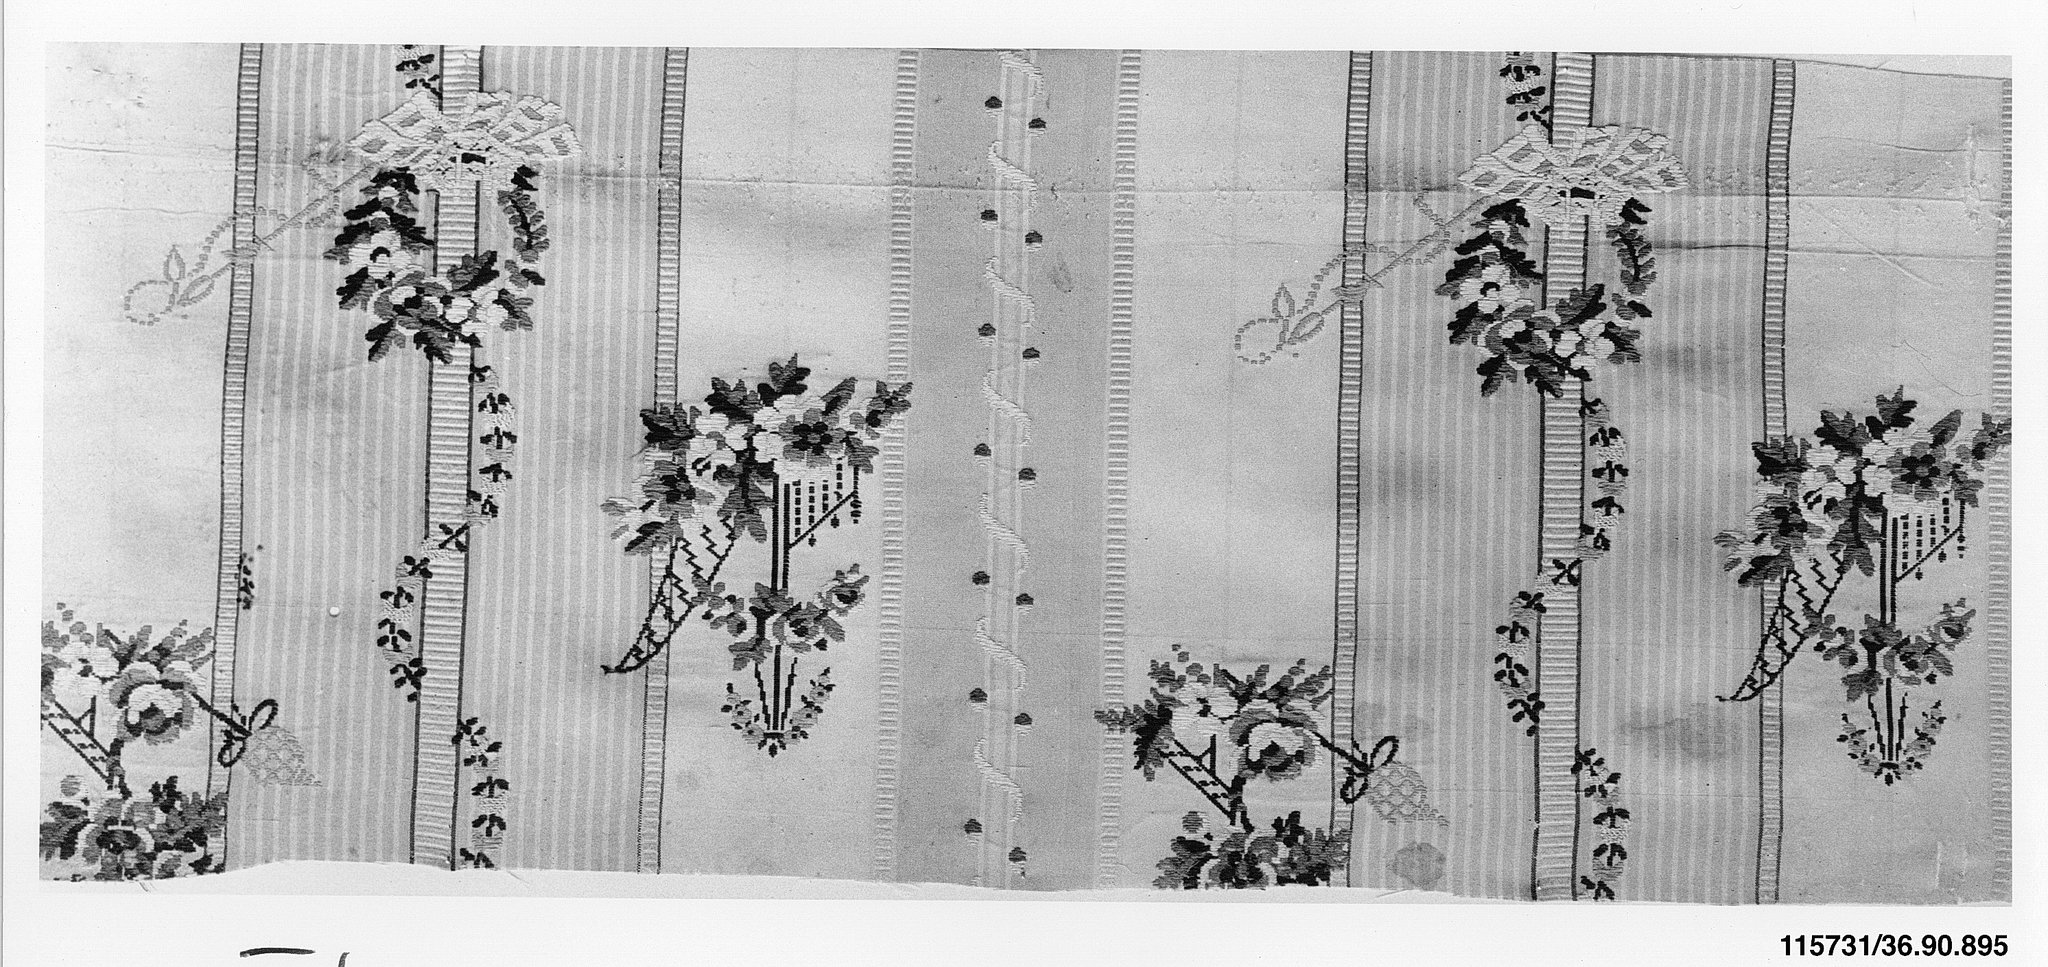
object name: piece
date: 1701-1800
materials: silk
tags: flowers,leaves